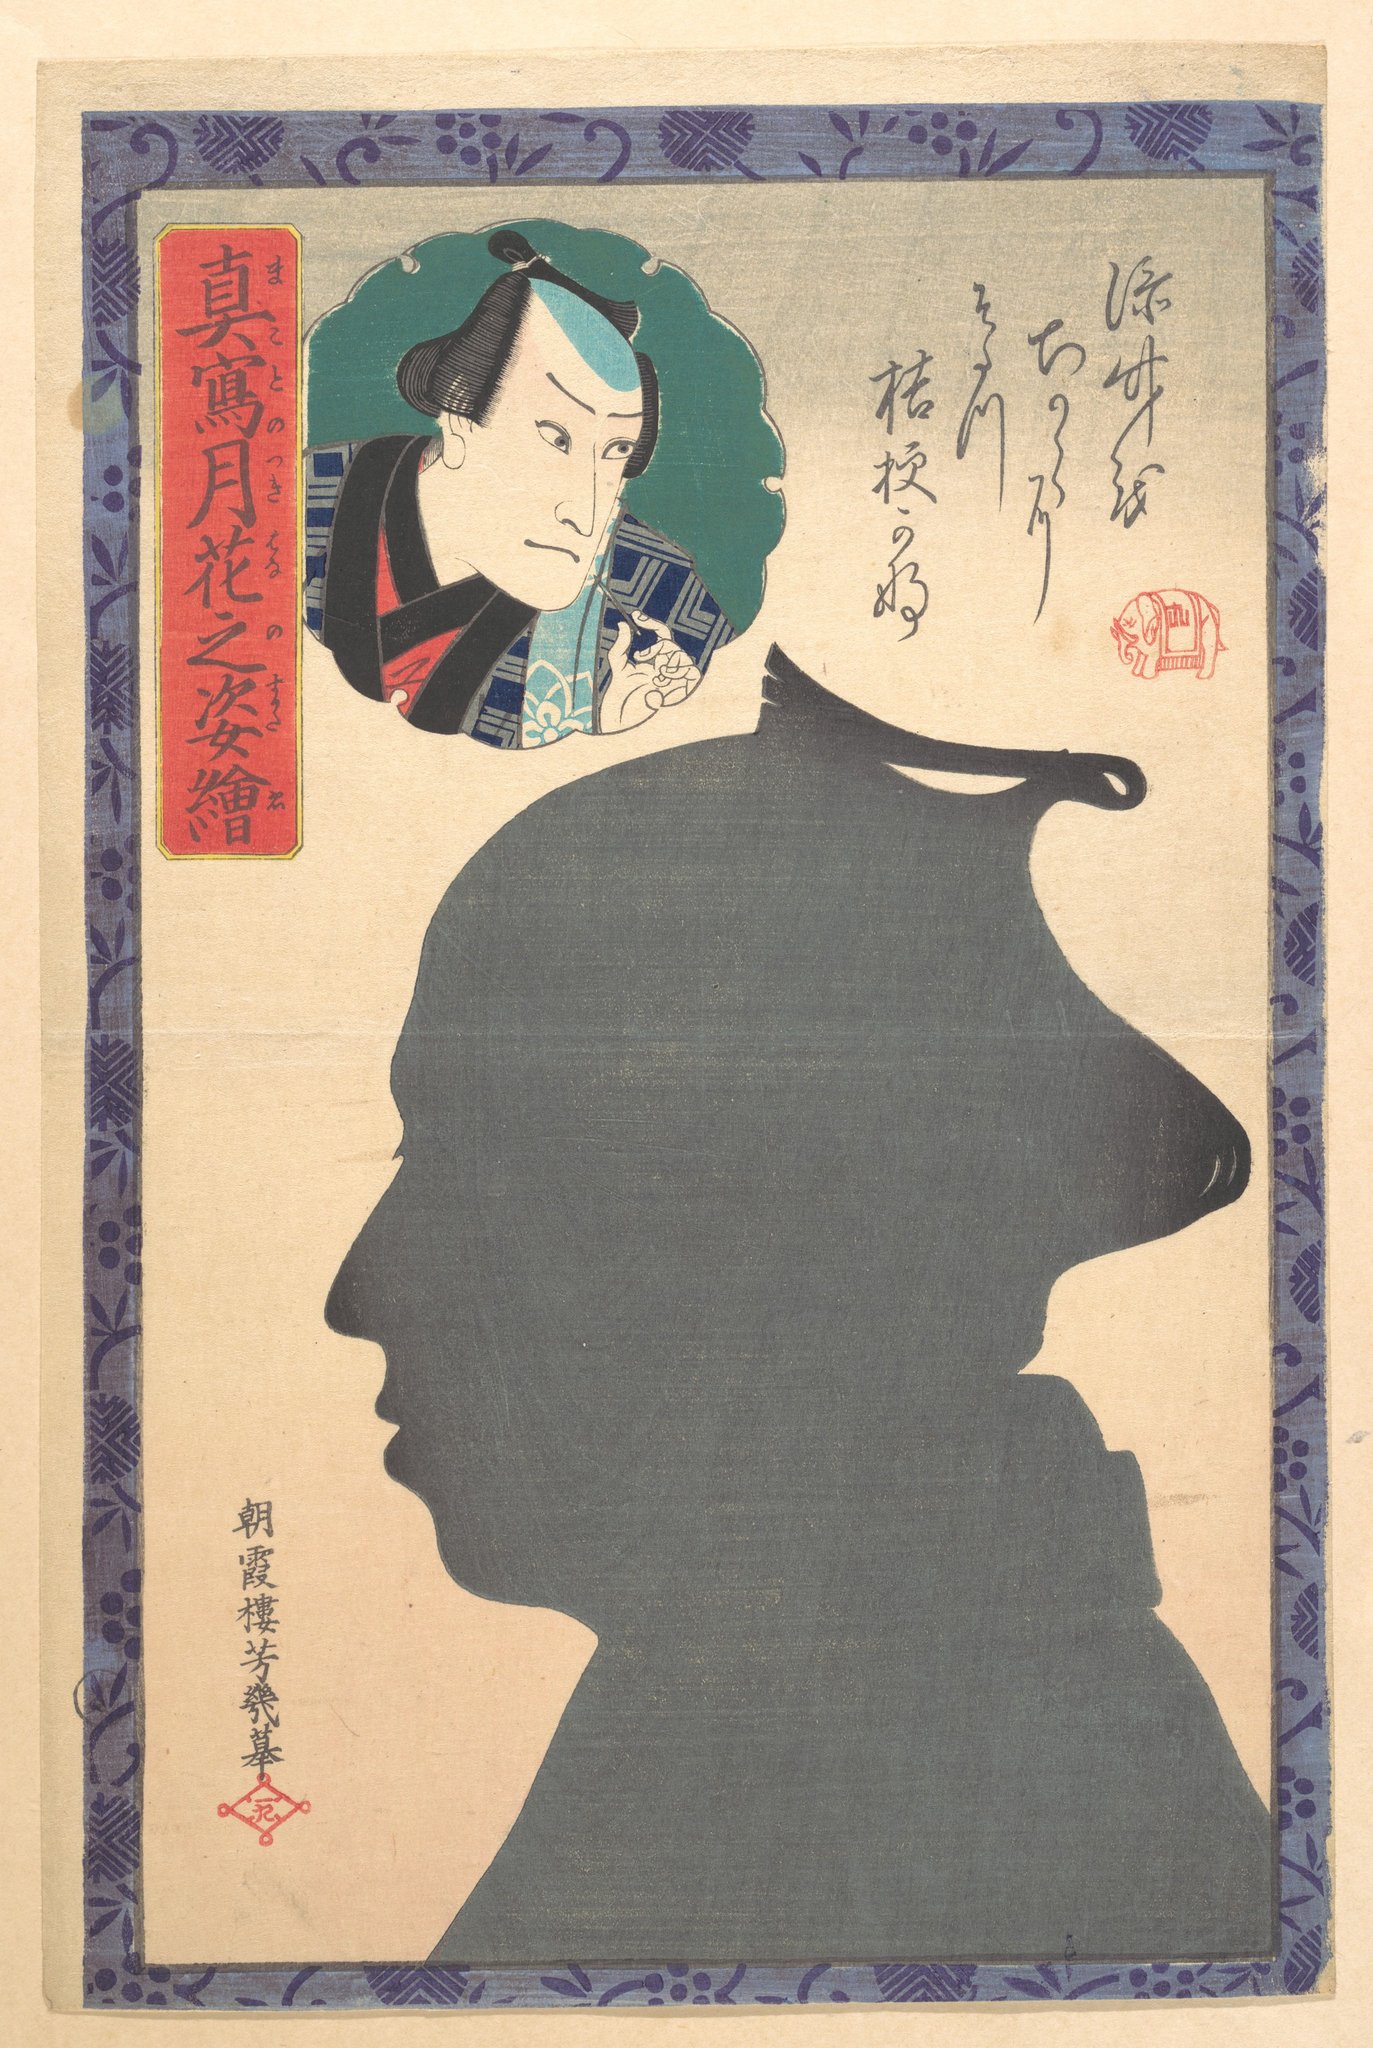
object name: print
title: Silhouette Image of Kabuki Actor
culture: japanese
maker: utagawa yoshiiku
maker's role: artist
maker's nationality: japanese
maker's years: 1833-1904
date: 1801-1900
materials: ink, paper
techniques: woodblock print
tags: men,profiles,actors